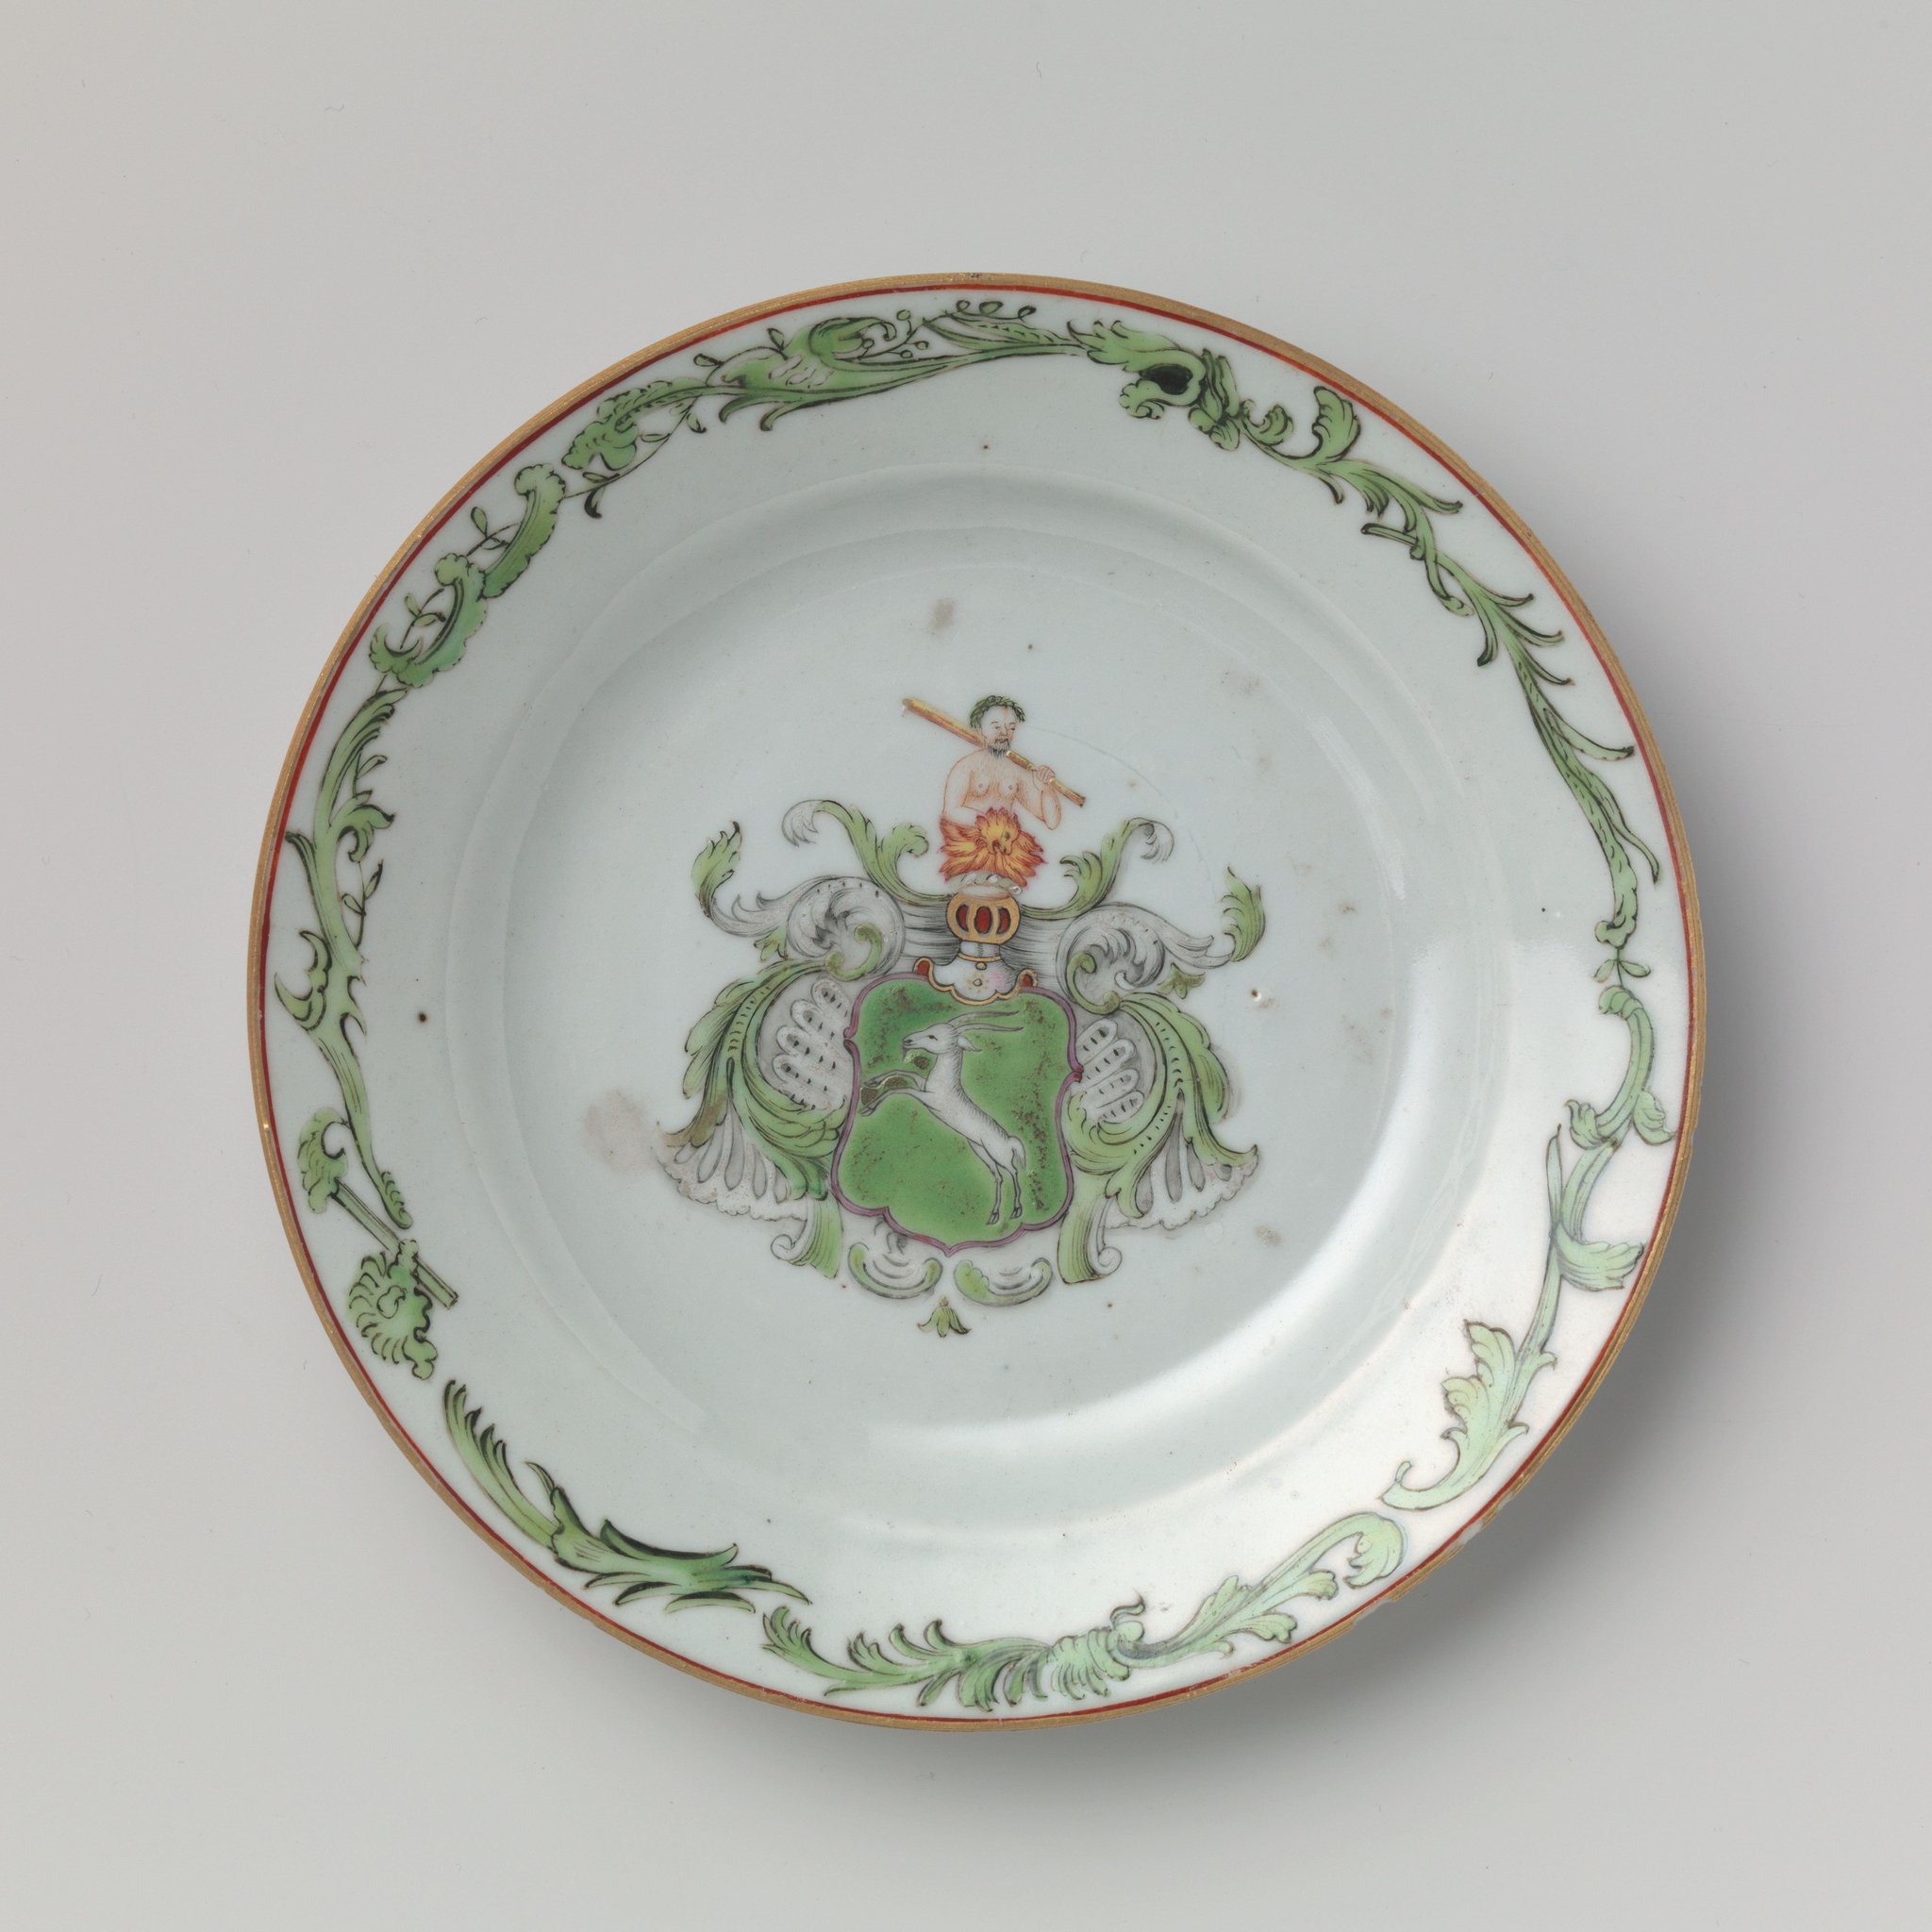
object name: plate dish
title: Plate with the arms of the De Wilde family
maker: Anonymous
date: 1740-1760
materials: glaze, gold, paint, porcelain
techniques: firing, gilding, turning, vitrification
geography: china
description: Bord van porselein, beschilderd op het glazuur in rood, roze, groen, geel, zwart en goud. Op het plat het wapen van de familie De Wilde (een springende geit). Het helmteken is een leeuwenhoofd met manen met daarboven een wilde man of barbaar die een knots vasthoudt. Het dekkleed bestaat uit bladranken in Europese stijl. Op de rand een loofwerk van bladranken en palmtakken in rococo-stijl. Wapenporselein met emailkleuren.